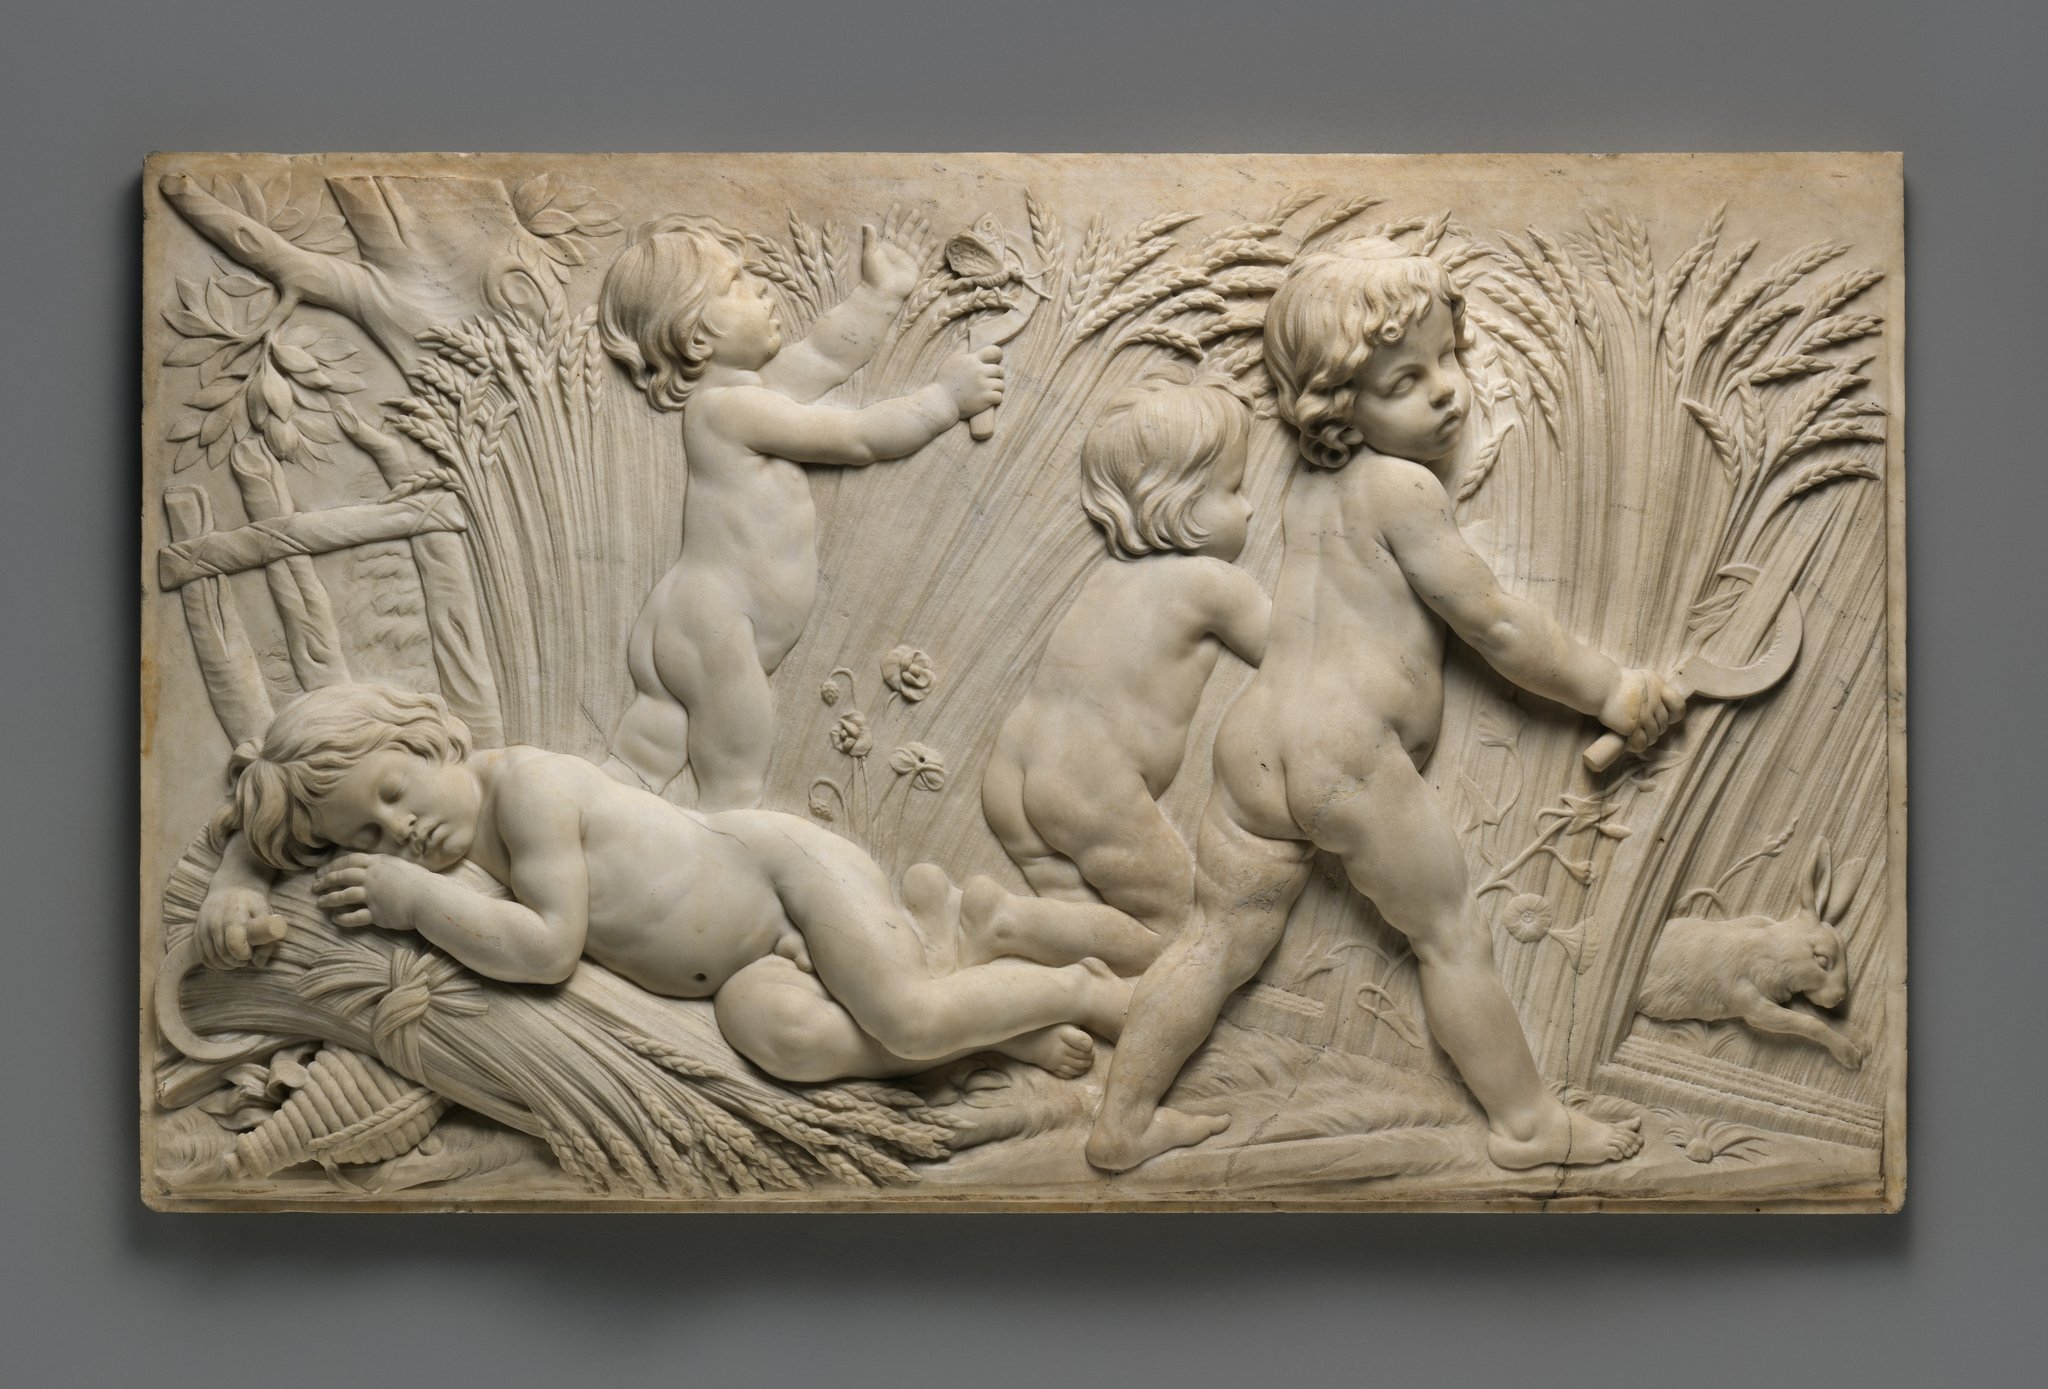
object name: relief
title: Summer (one of a set of four)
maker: edme bouchardon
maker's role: artist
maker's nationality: french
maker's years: 1698-1762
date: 1734-1766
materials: marble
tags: children,rabbits,summer